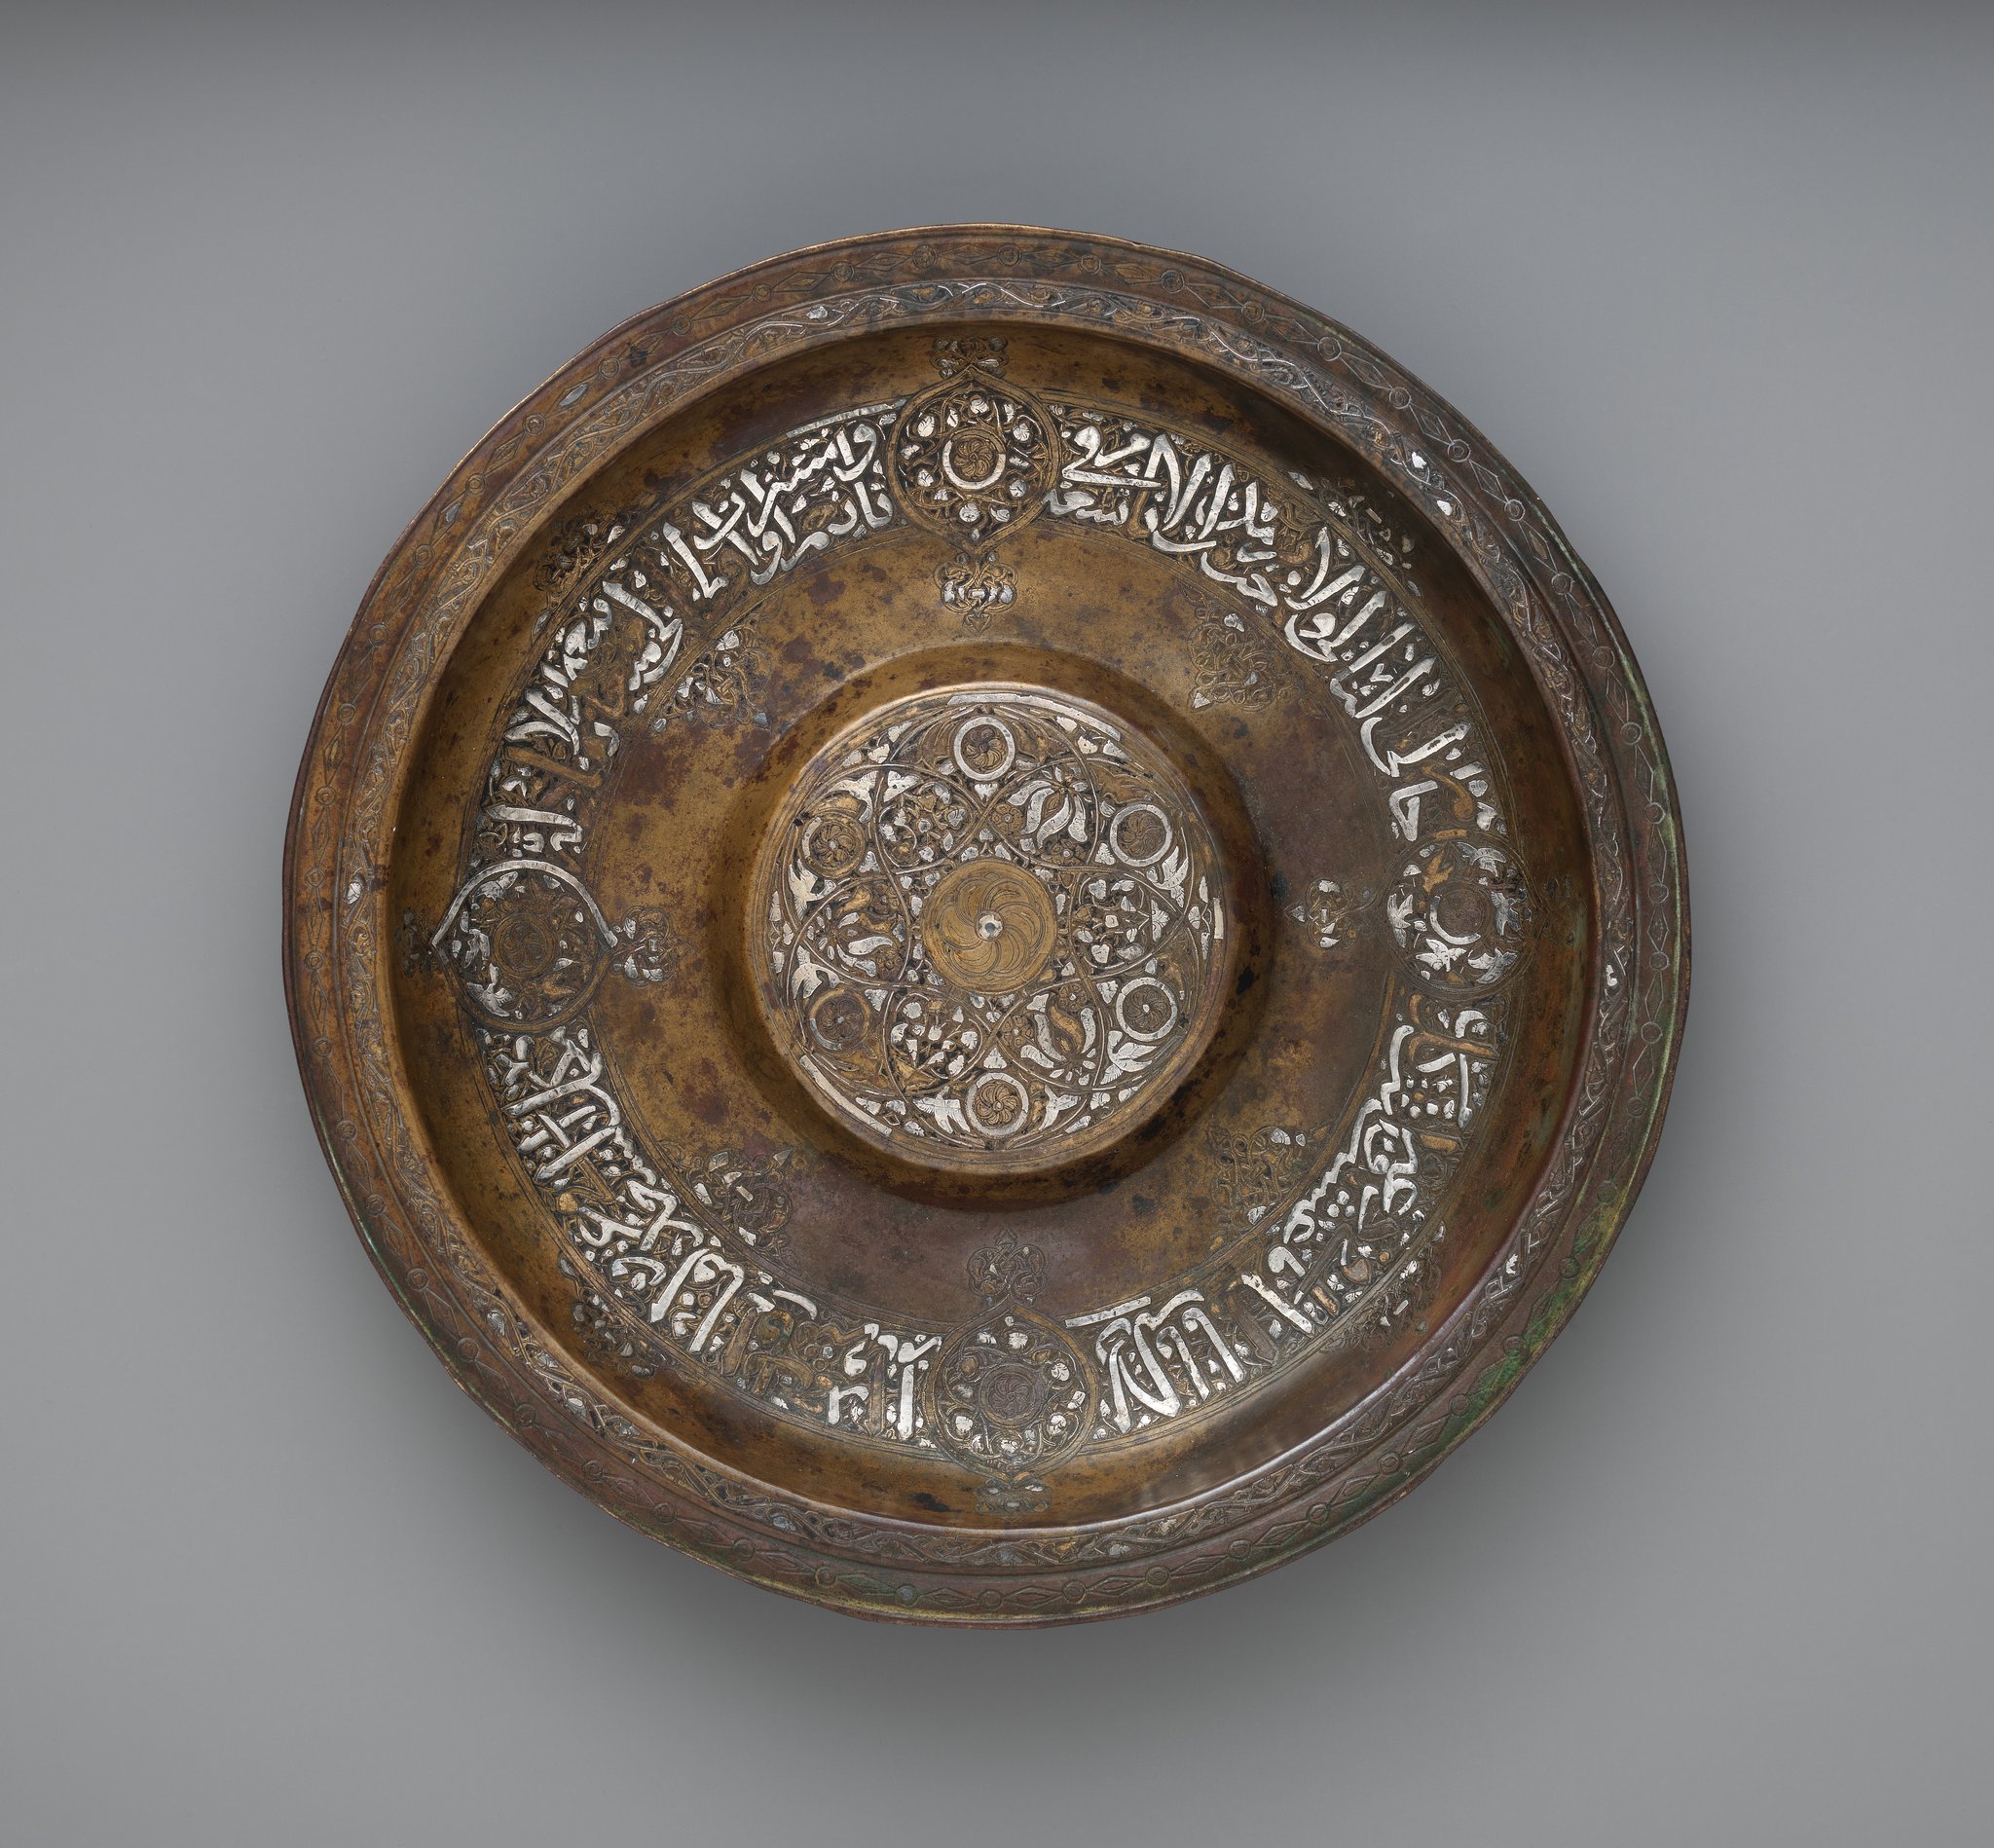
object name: dish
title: Mamluk Philae Dish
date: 1345-1360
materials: brass, gold, silver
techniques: inlay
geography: egypt or syria